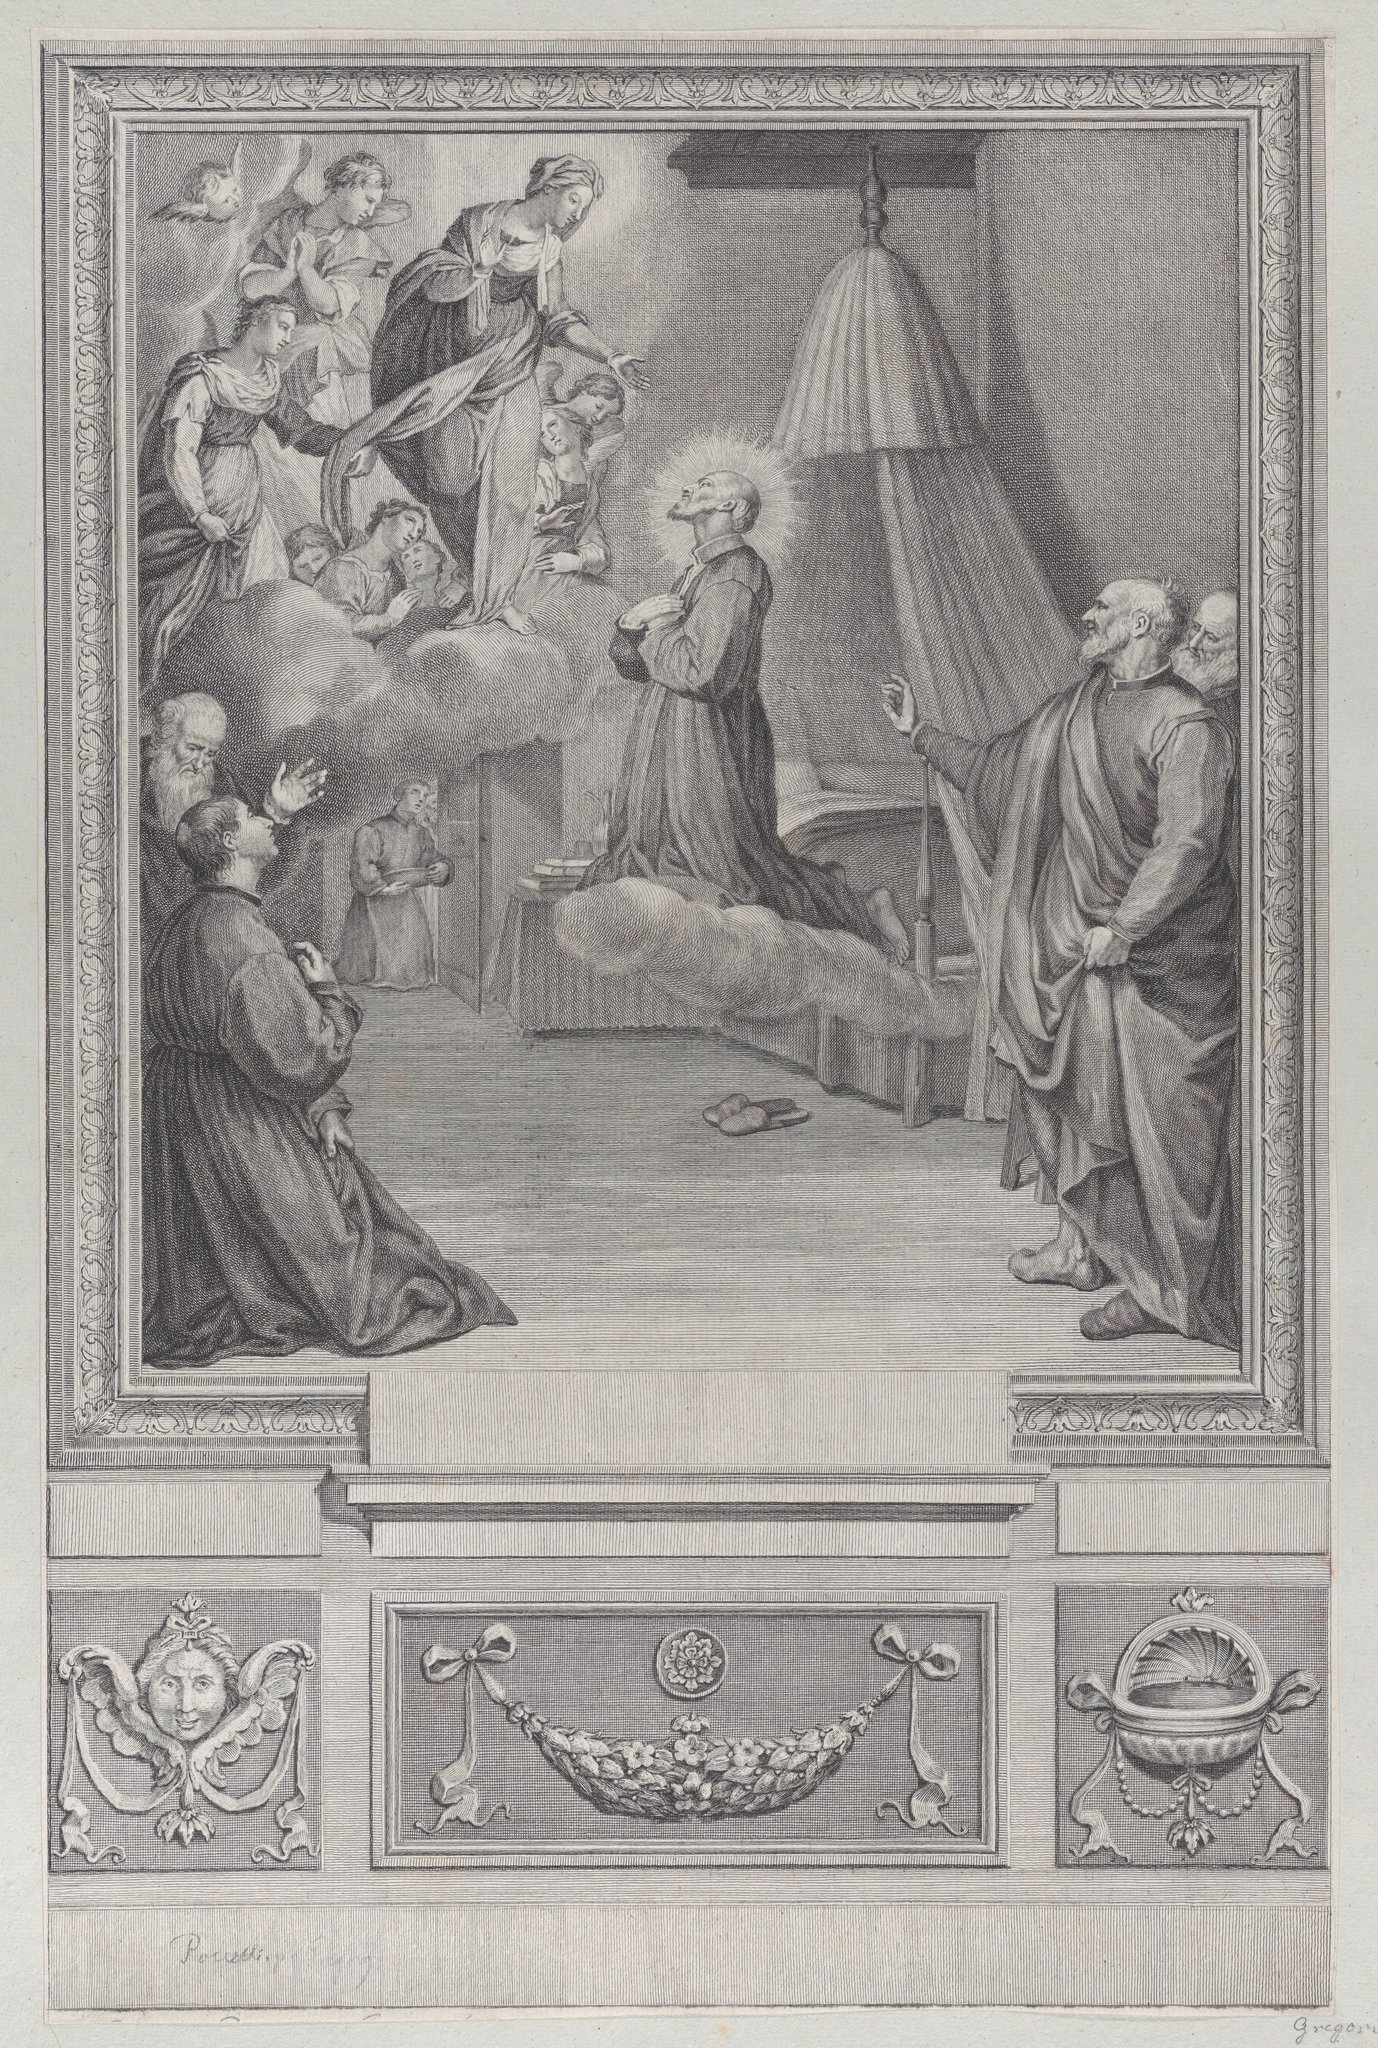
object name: print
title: Plate 27: The female personification of Fortitude, holding a pillar and stroking a lion; from the 'Galeria nel Palazzo Farnese in Roma ... dipinta da Annibale Caracci'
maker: carlo cesio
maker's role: artist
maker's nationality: italian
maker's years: 1622-1682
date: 1657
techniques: etching